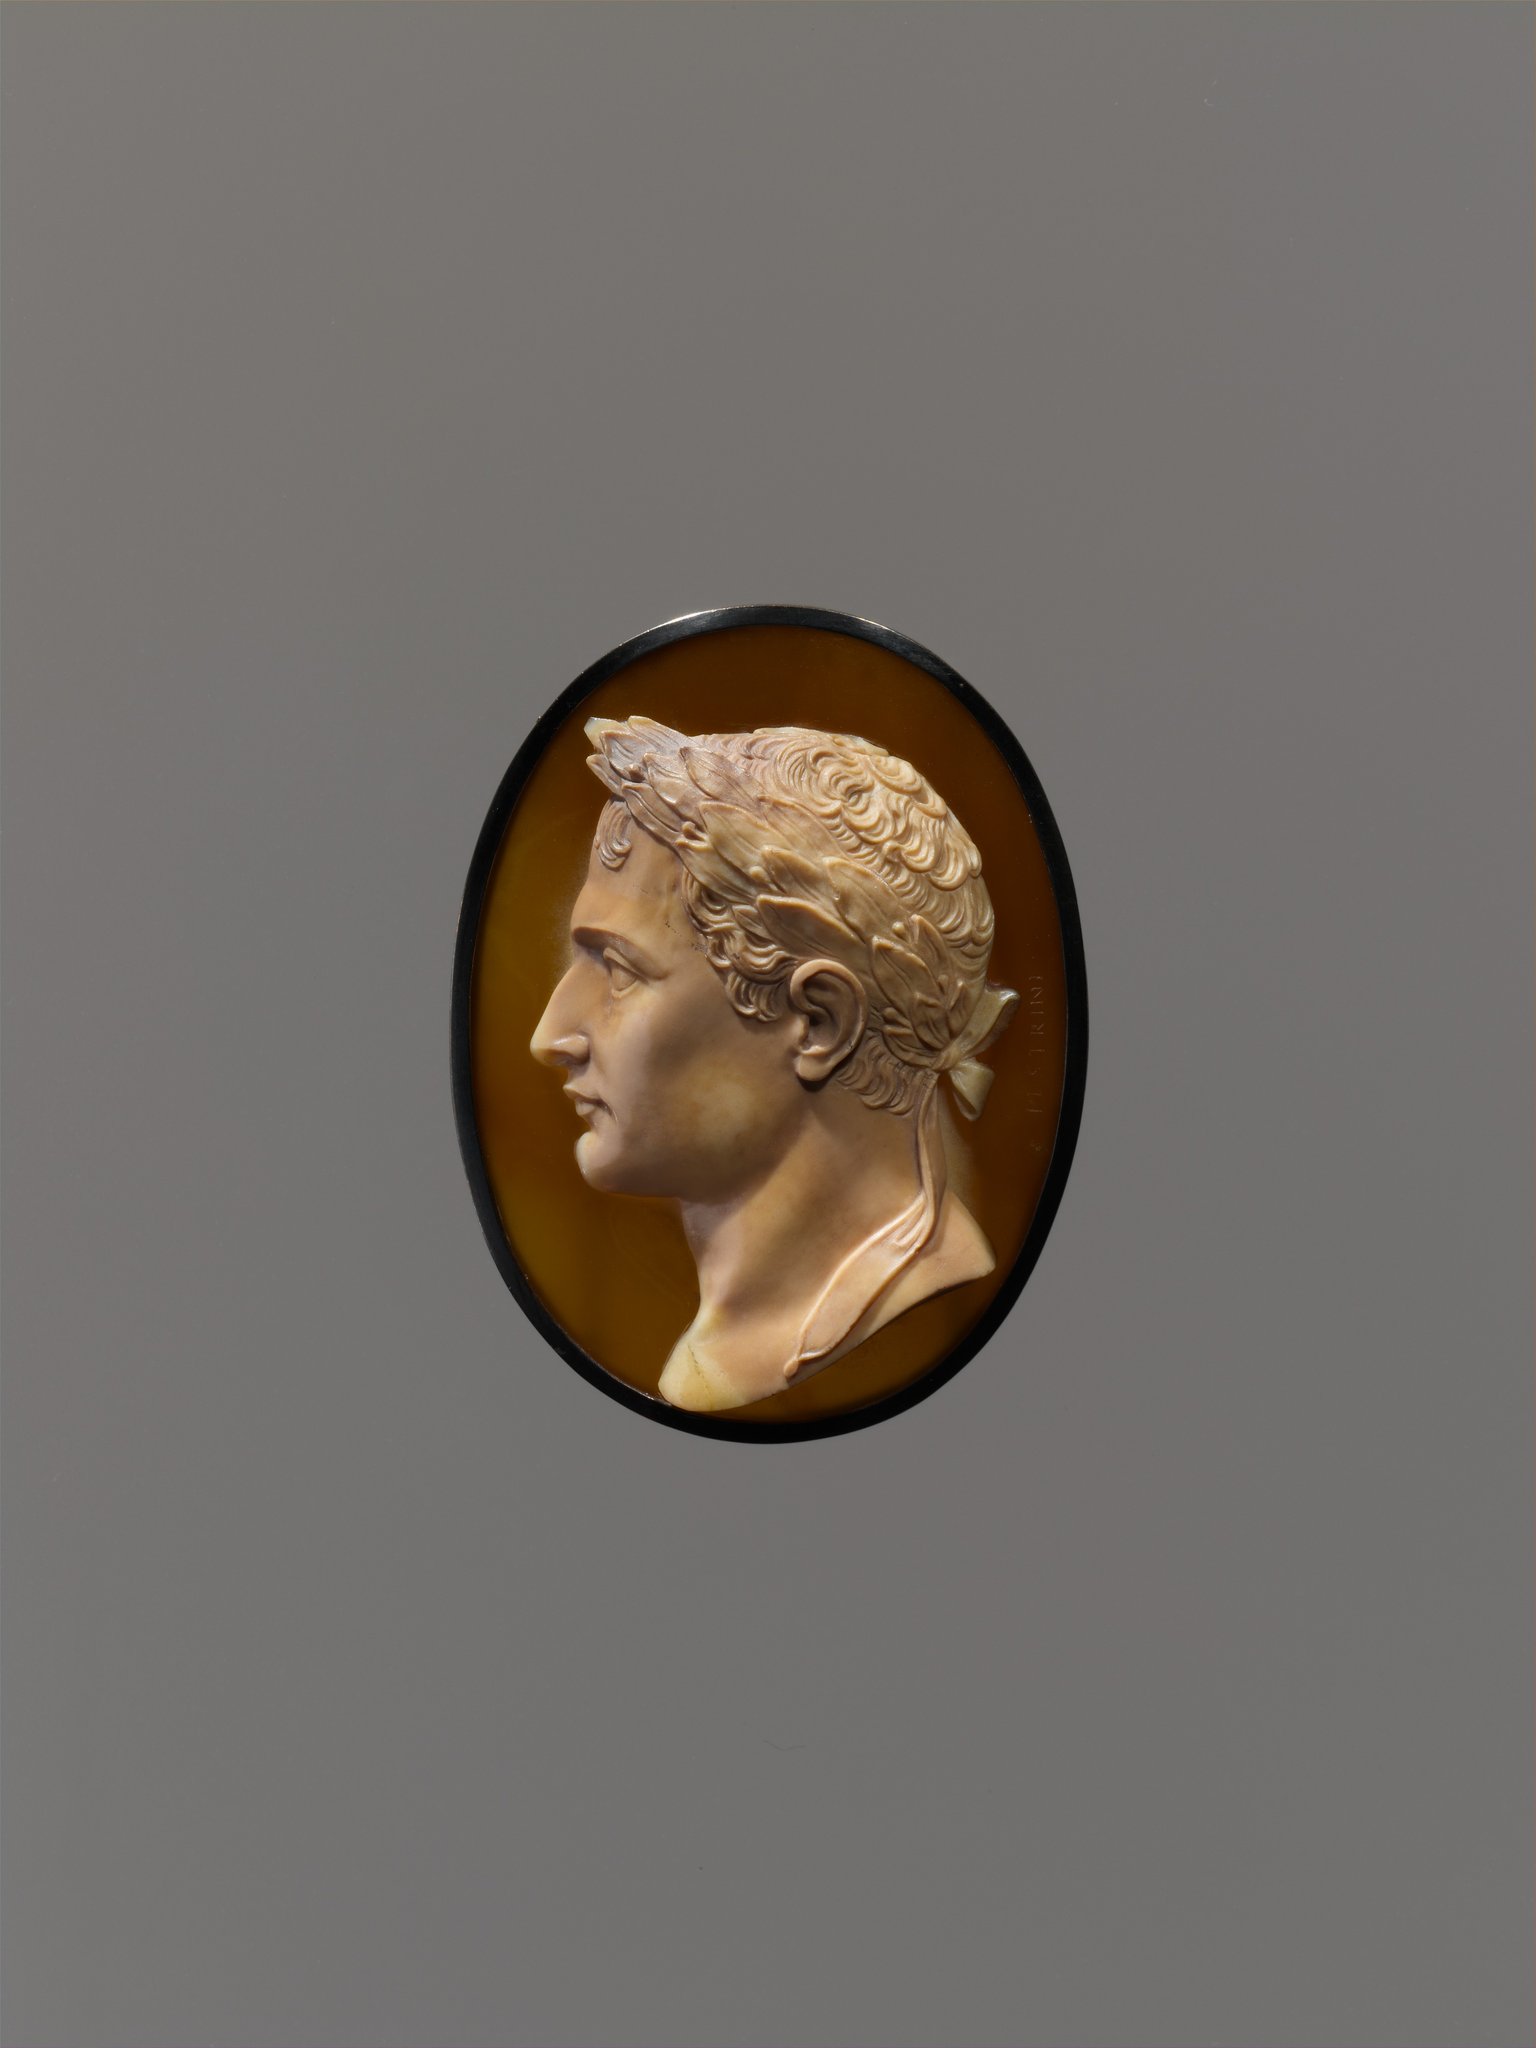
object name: cameo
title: Laureate head of Napoleon I of France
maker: pietro pestrini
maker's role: maker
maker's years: 1800-1850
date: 1810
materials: gold, gemstone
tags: napoleon i,heads,profiles,wreaths